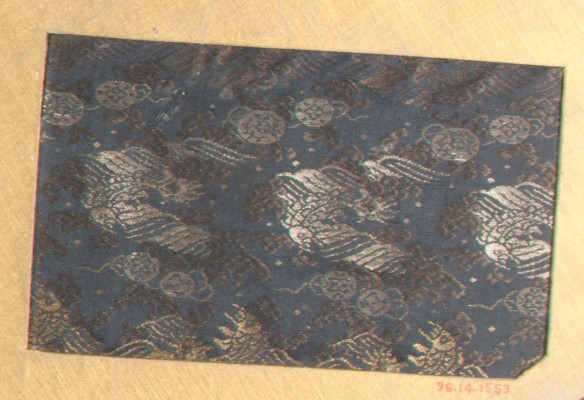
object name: piece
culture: japanese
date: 1701-1900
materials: silk